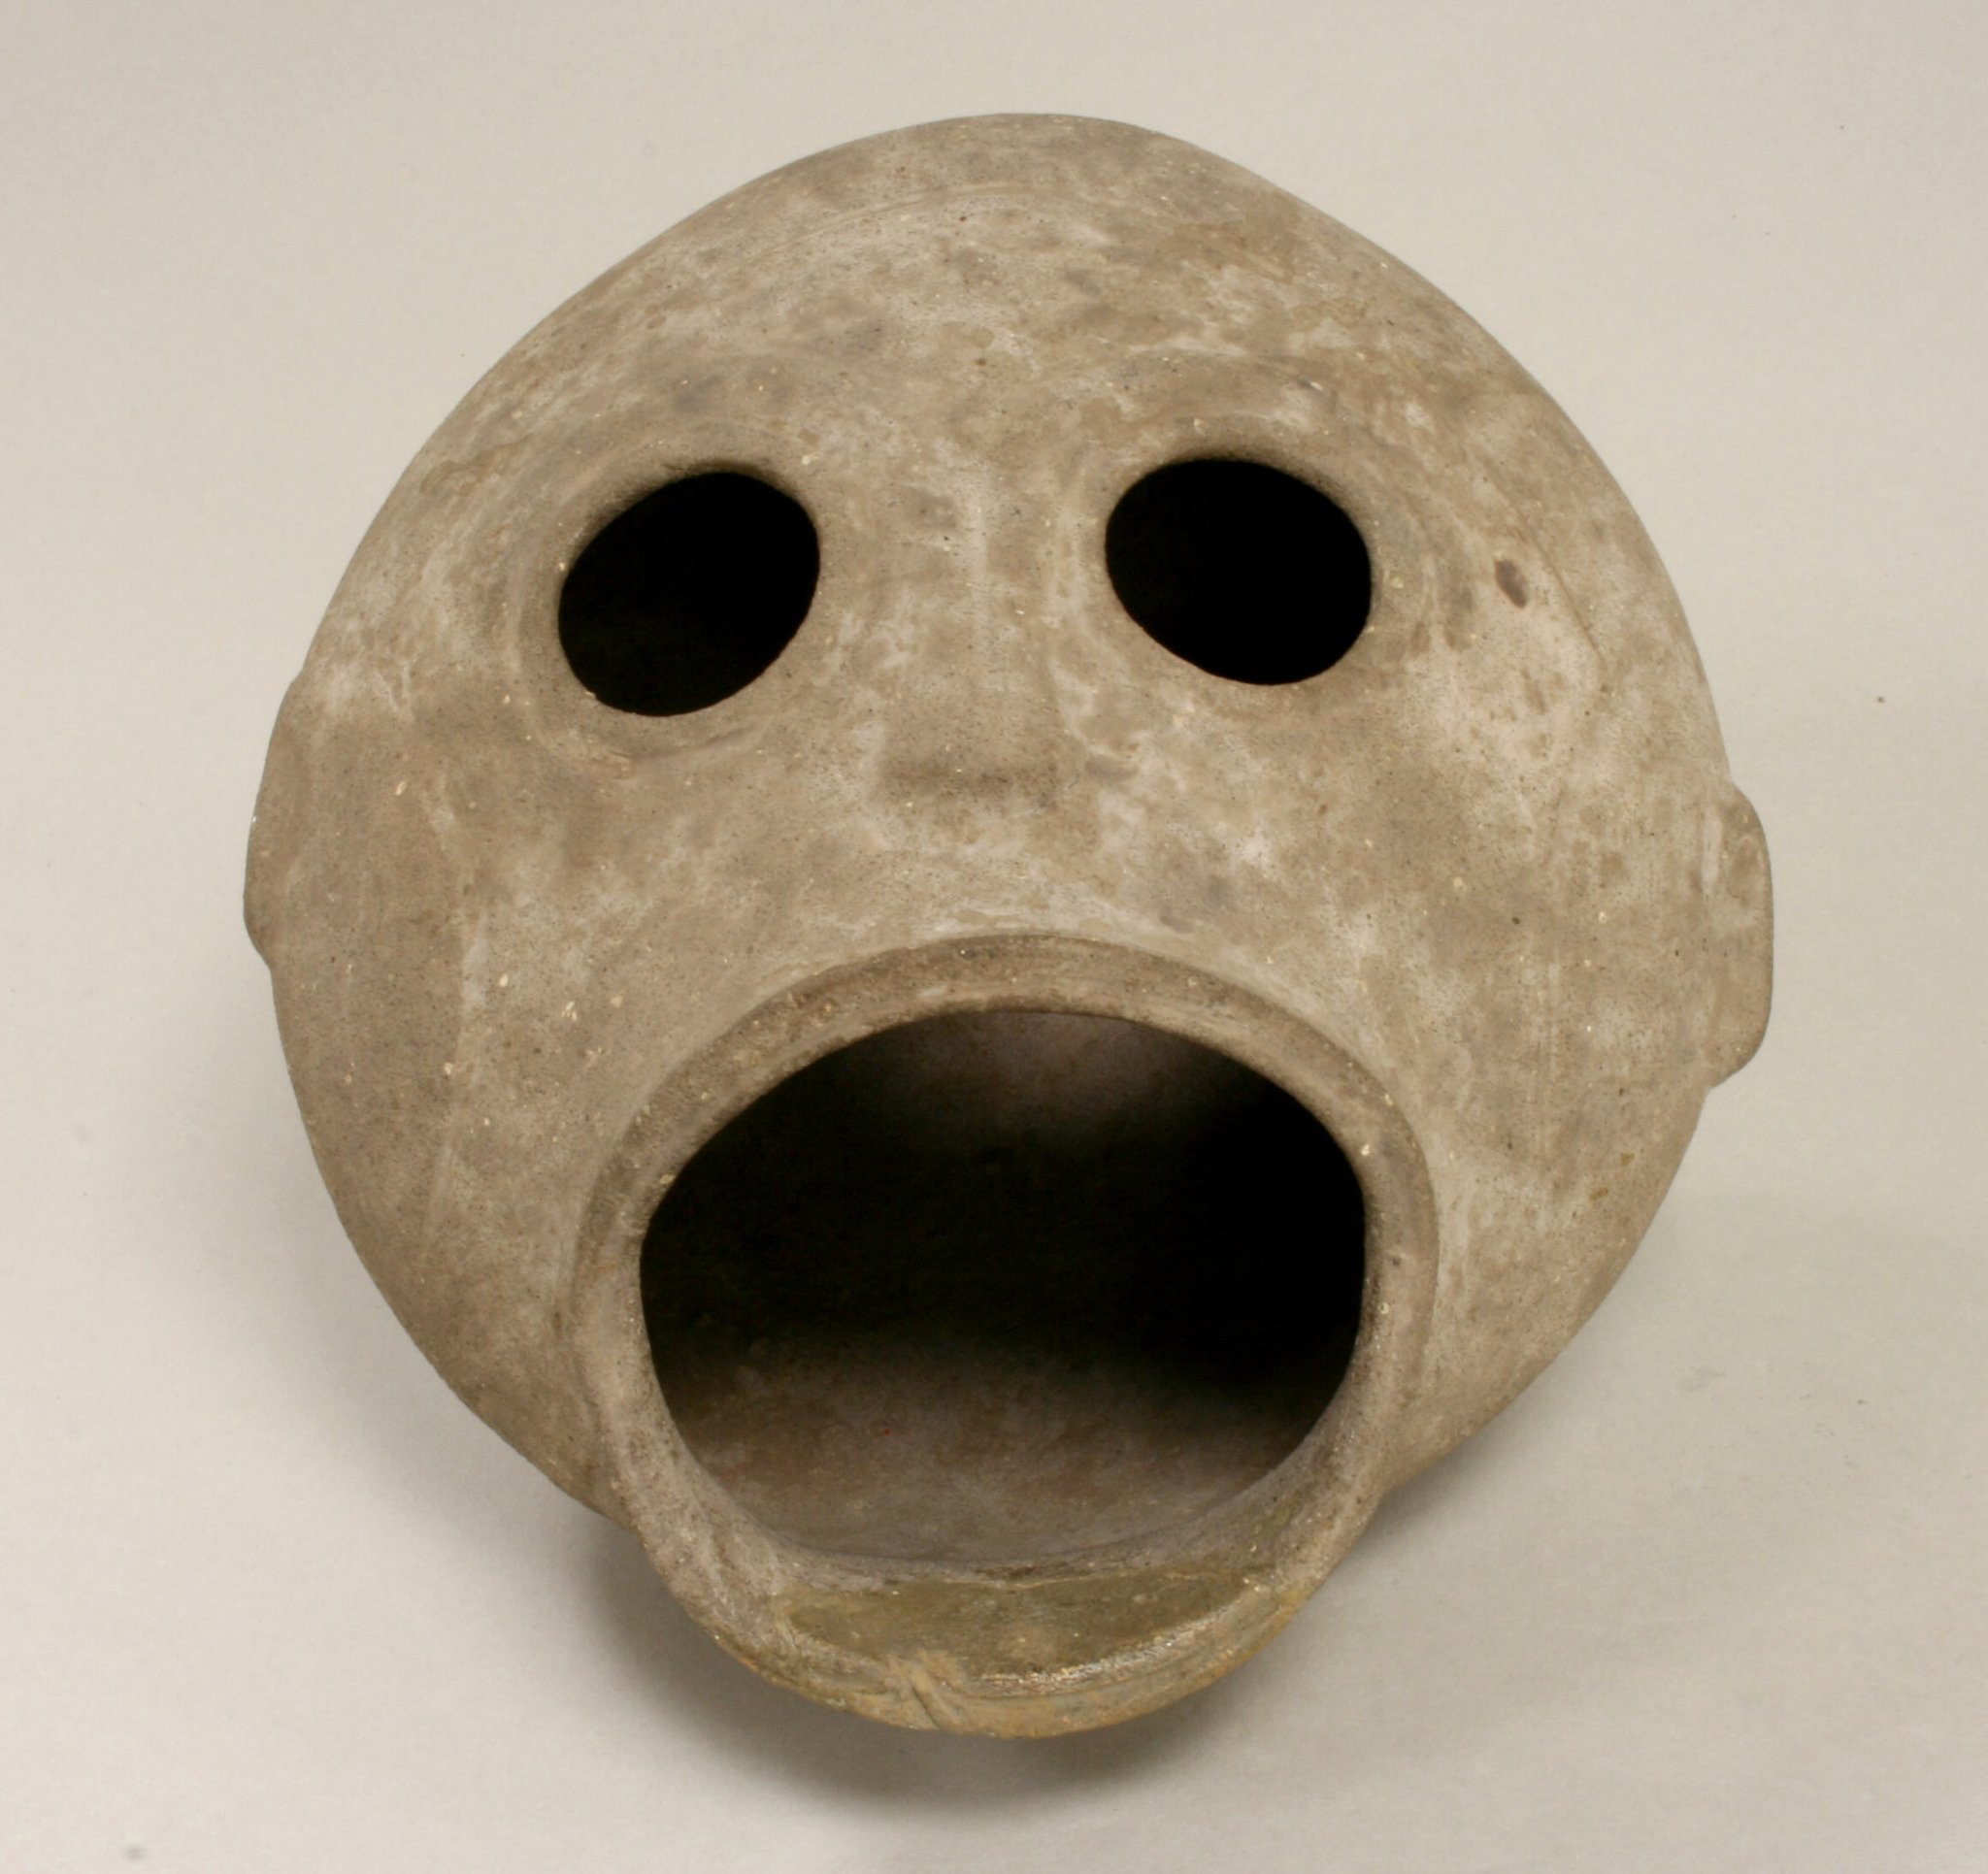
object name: vessel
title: Ceramic Monkey Head Vessel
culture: mexican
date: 1301-1500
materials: ceramic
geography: mexico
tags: monkeys